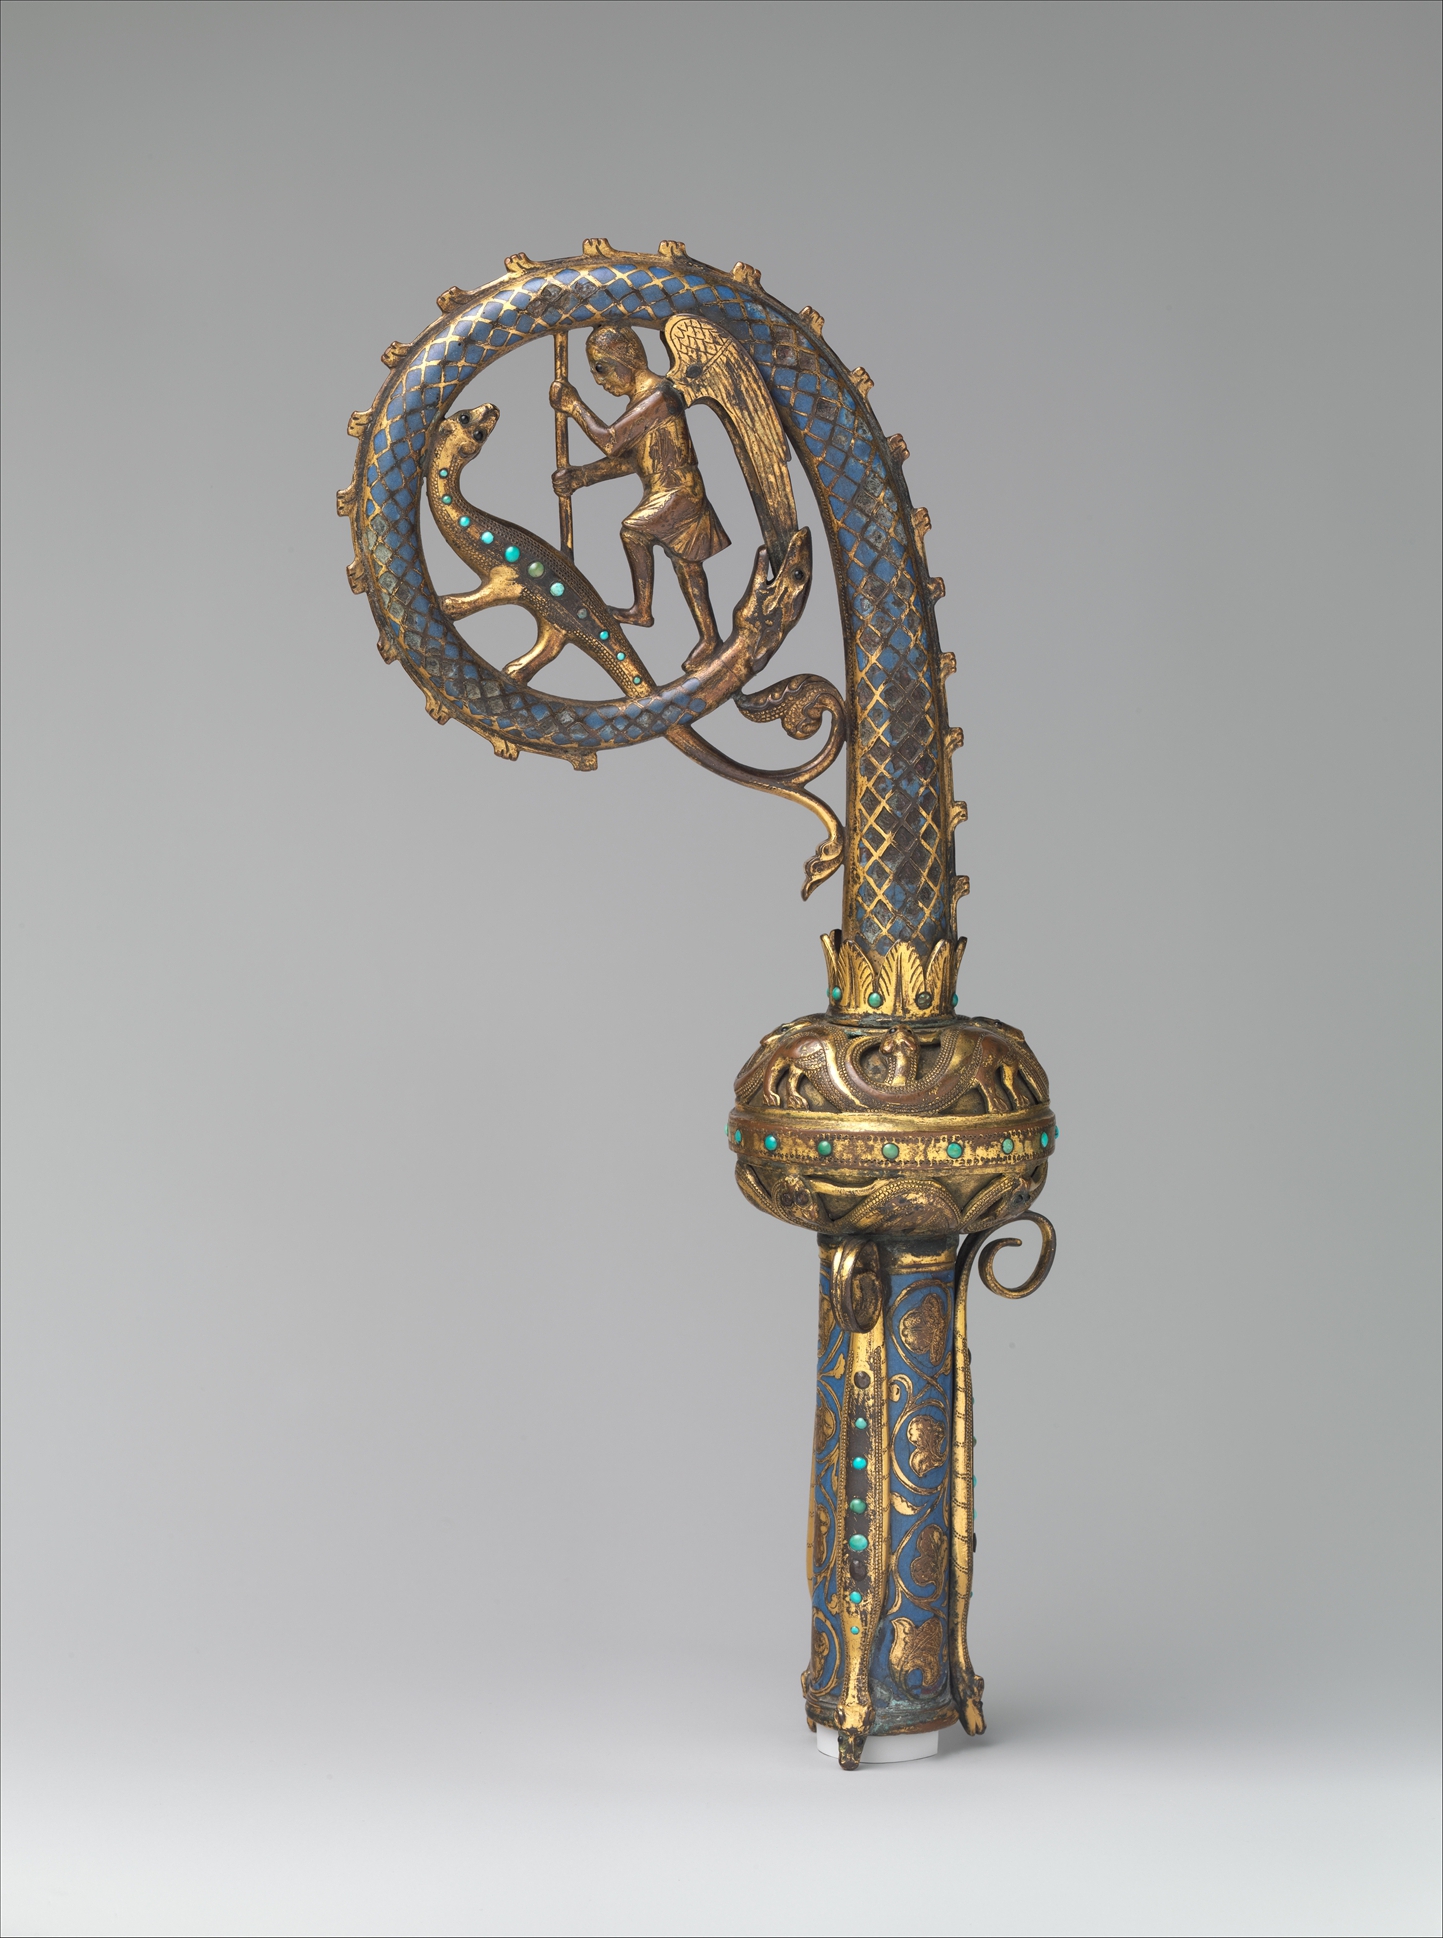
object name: crozier head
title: Head of a Crozier with Saint Michael Slaying the Dragon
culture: french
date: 1220-1230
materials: gilt copper, enamel, glass, paste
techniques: enamel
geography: france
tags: dragons